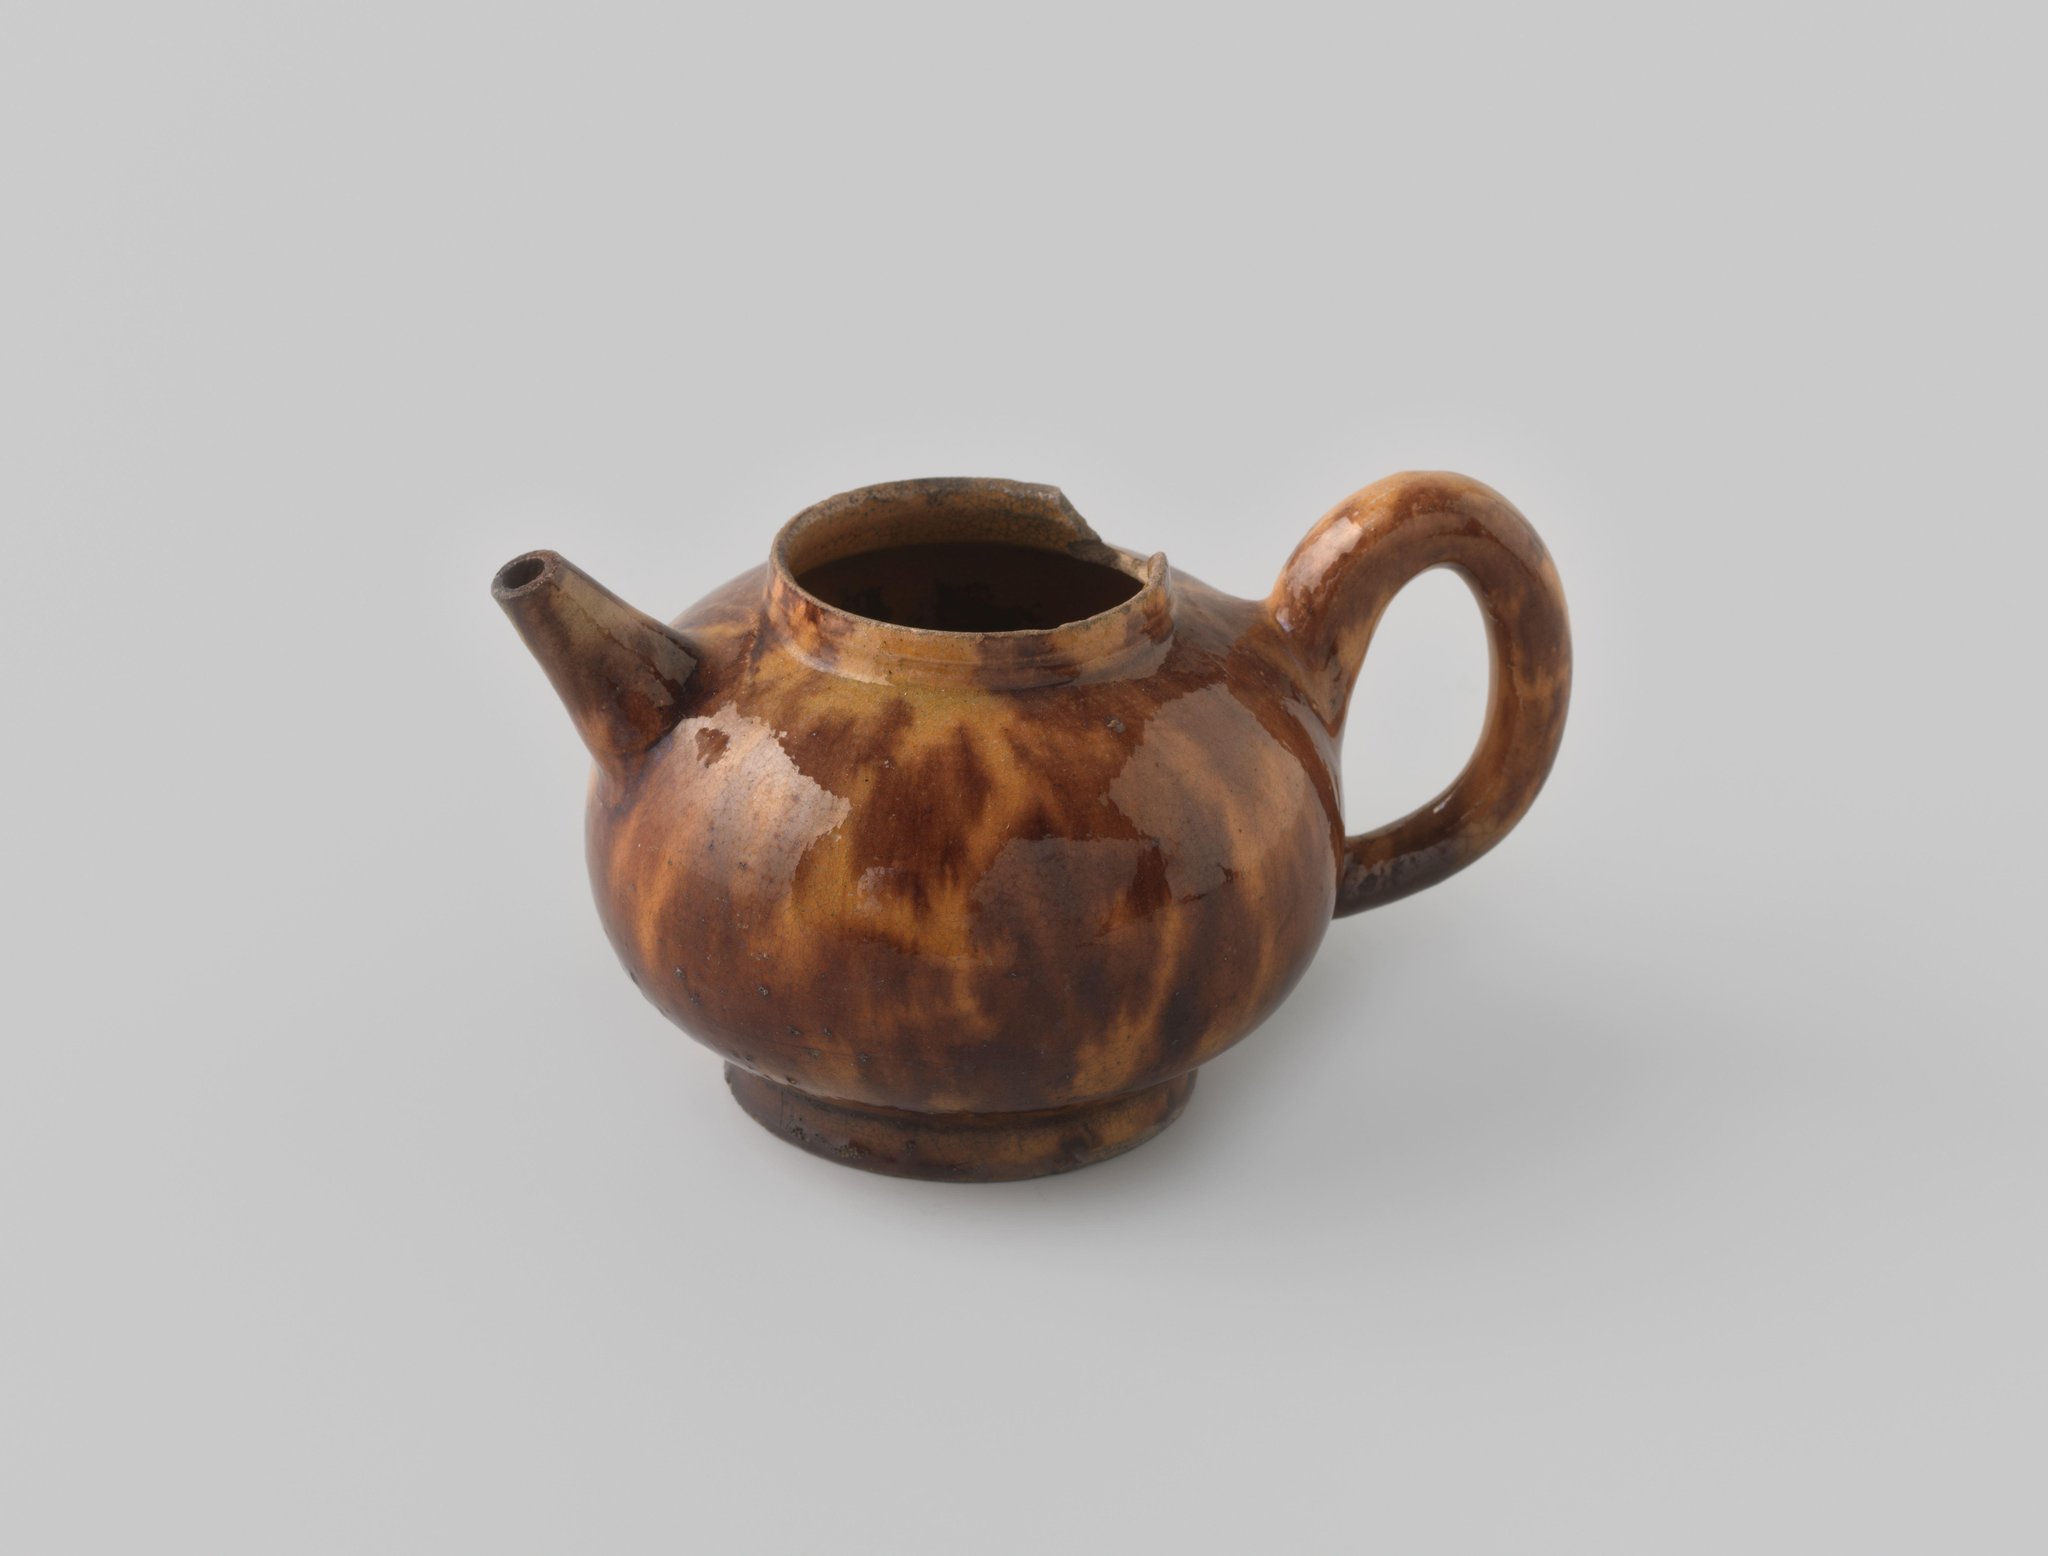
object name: fragment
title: Theepot van roodbakkend aardewerk, beschadigd, voorzien van gewolkt glazuur in beige en bruin aan de buitenzijde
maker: Anonymous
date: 1600-1899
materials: glaze, stoneware